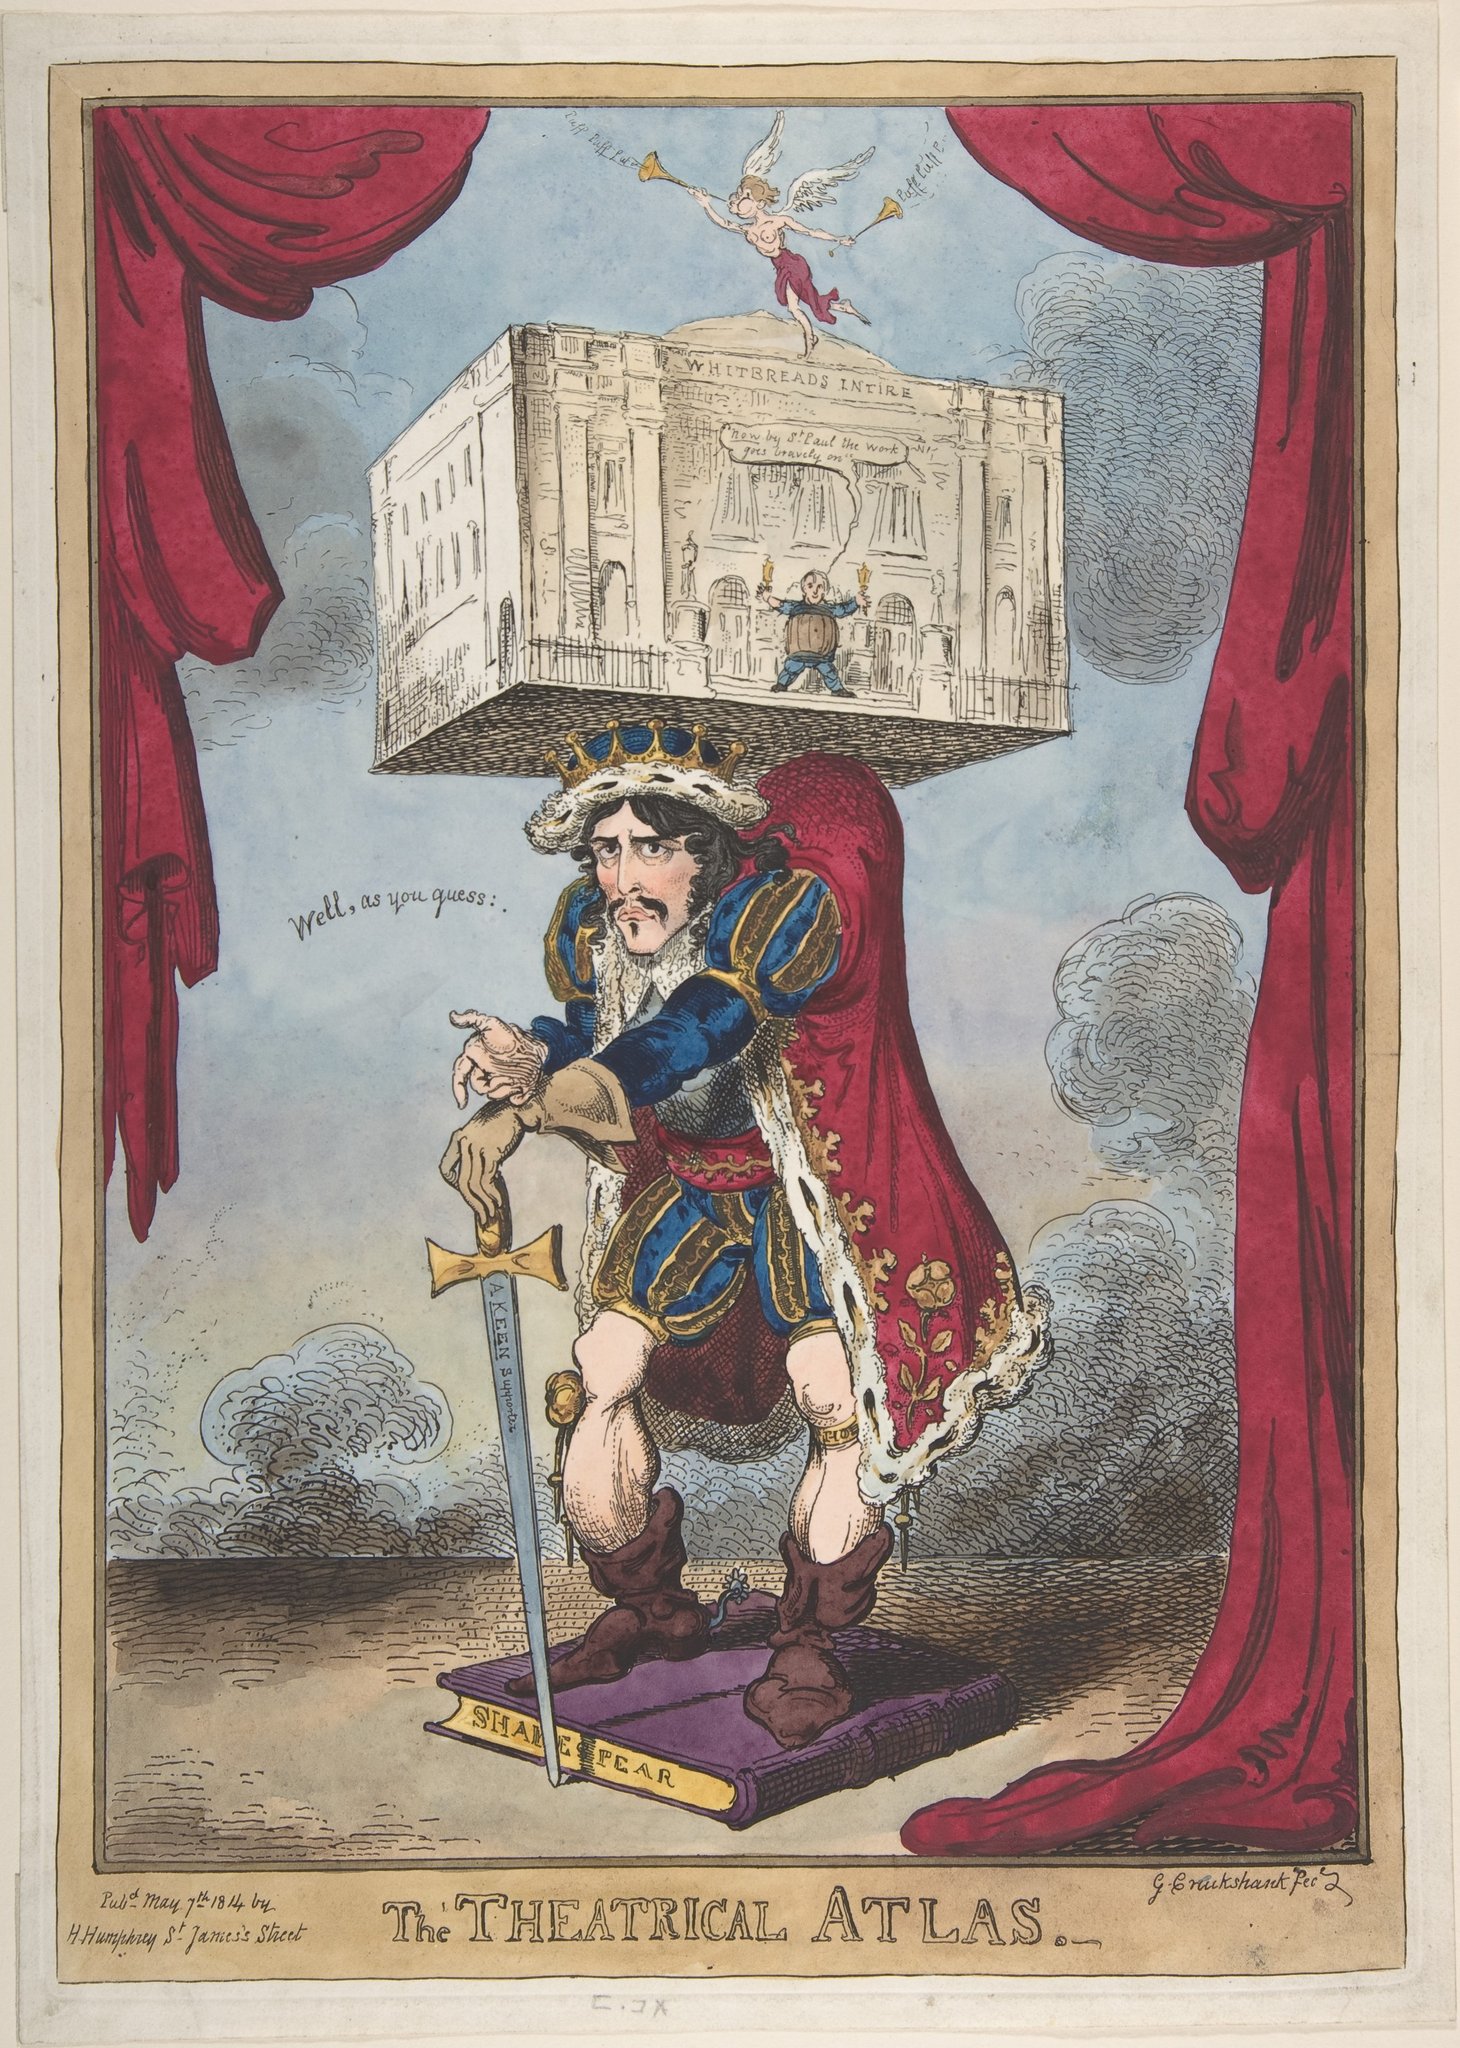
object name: print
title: The Theatrical Atlas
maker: george cruikshank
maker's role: artist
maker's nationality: british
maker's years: 1792-1878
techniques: etching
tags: satire,theatre,shakespeare,men